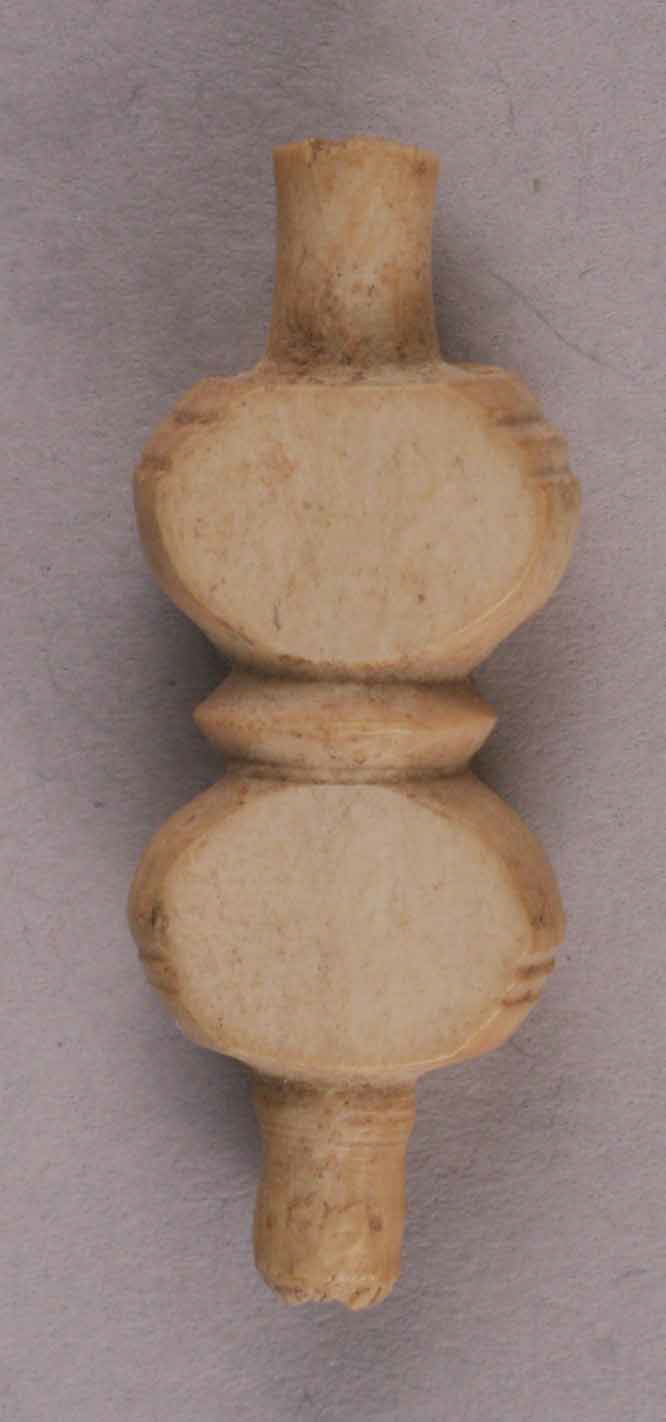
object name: handle or ornament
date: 801-1000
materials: bone, paint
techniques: carving, incising, inlay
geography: iran